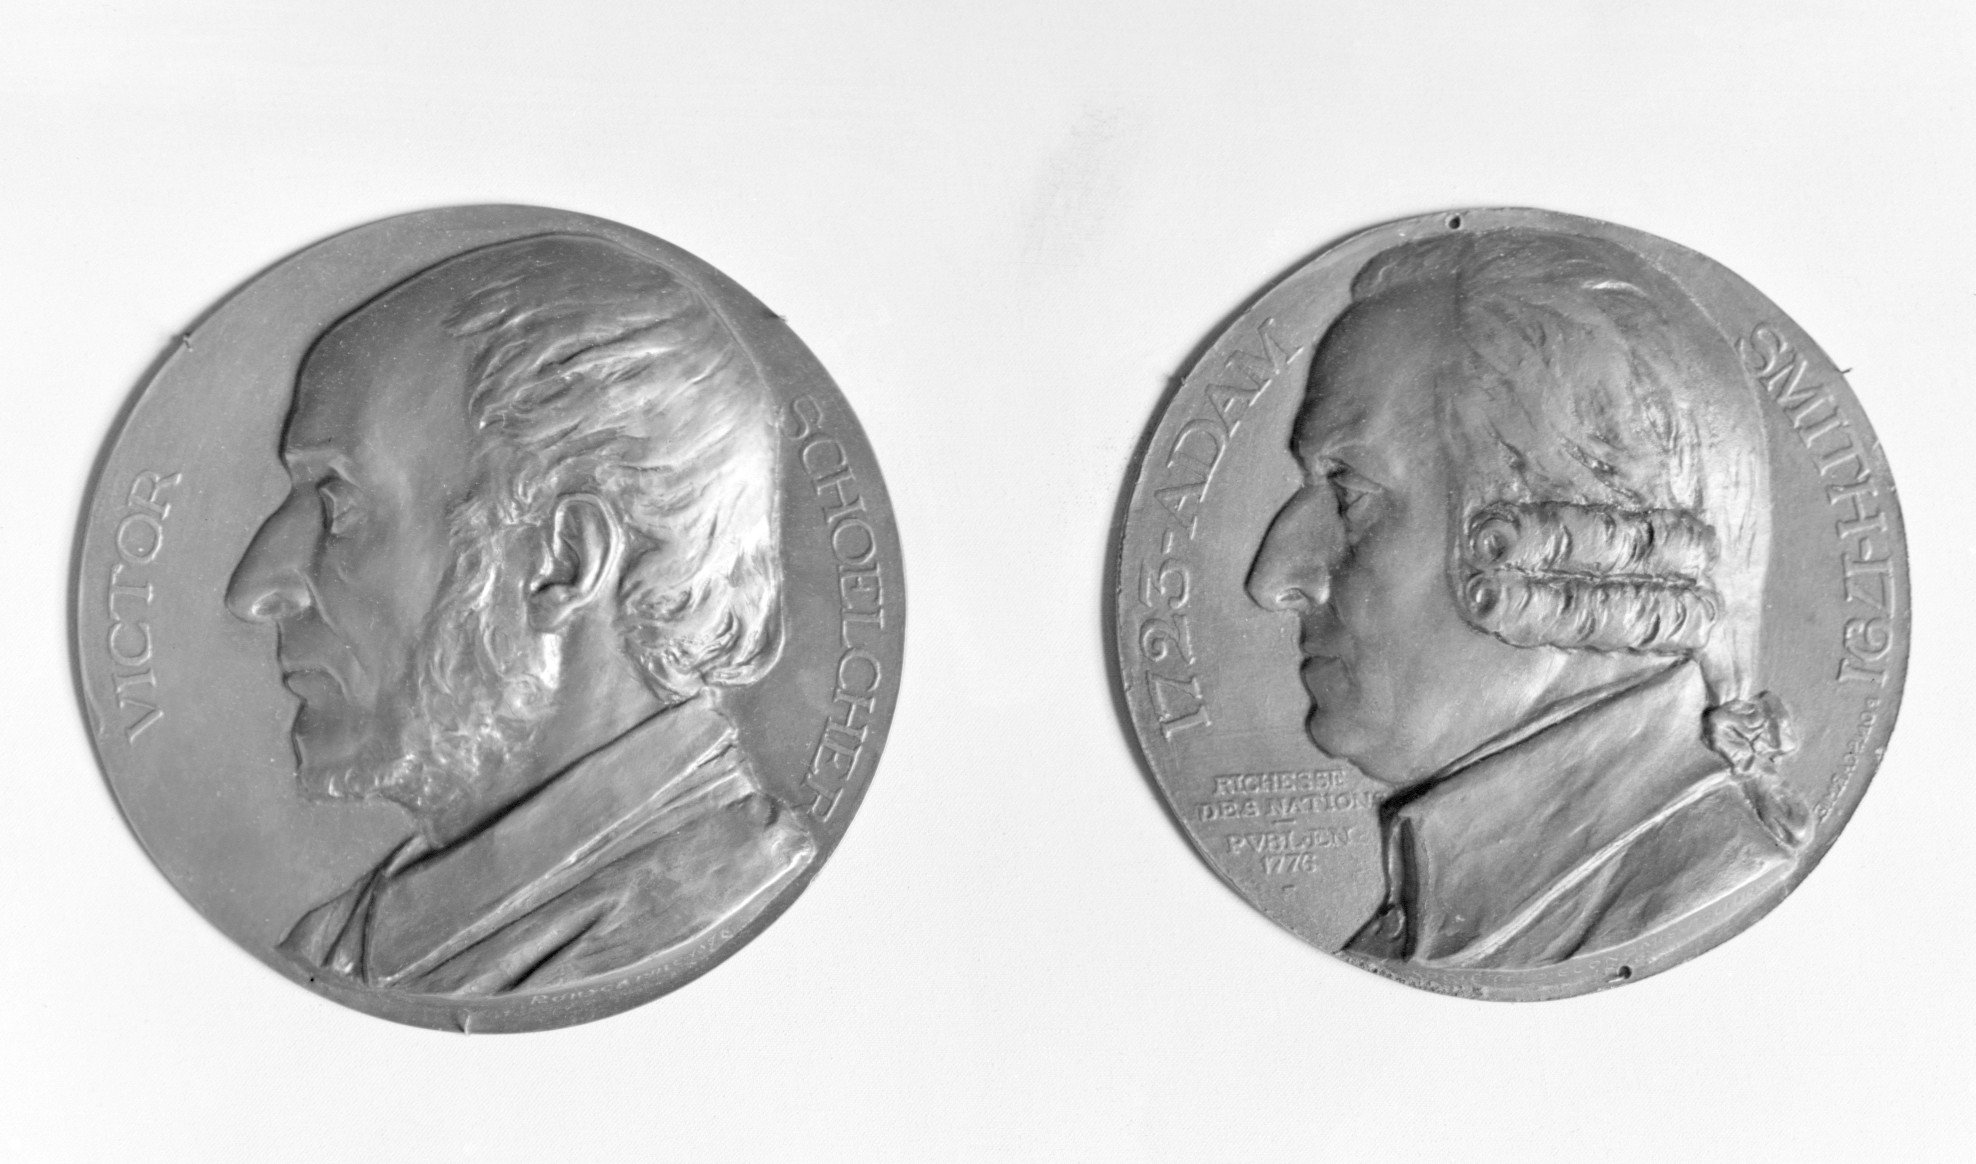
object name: medallion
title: Adam Smith, Political Economist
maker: françois-joseph-hubert ponscarme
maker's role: artist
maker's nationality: french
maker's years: 1827-1903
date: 1876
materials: bronze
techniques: casting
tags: men,profiles